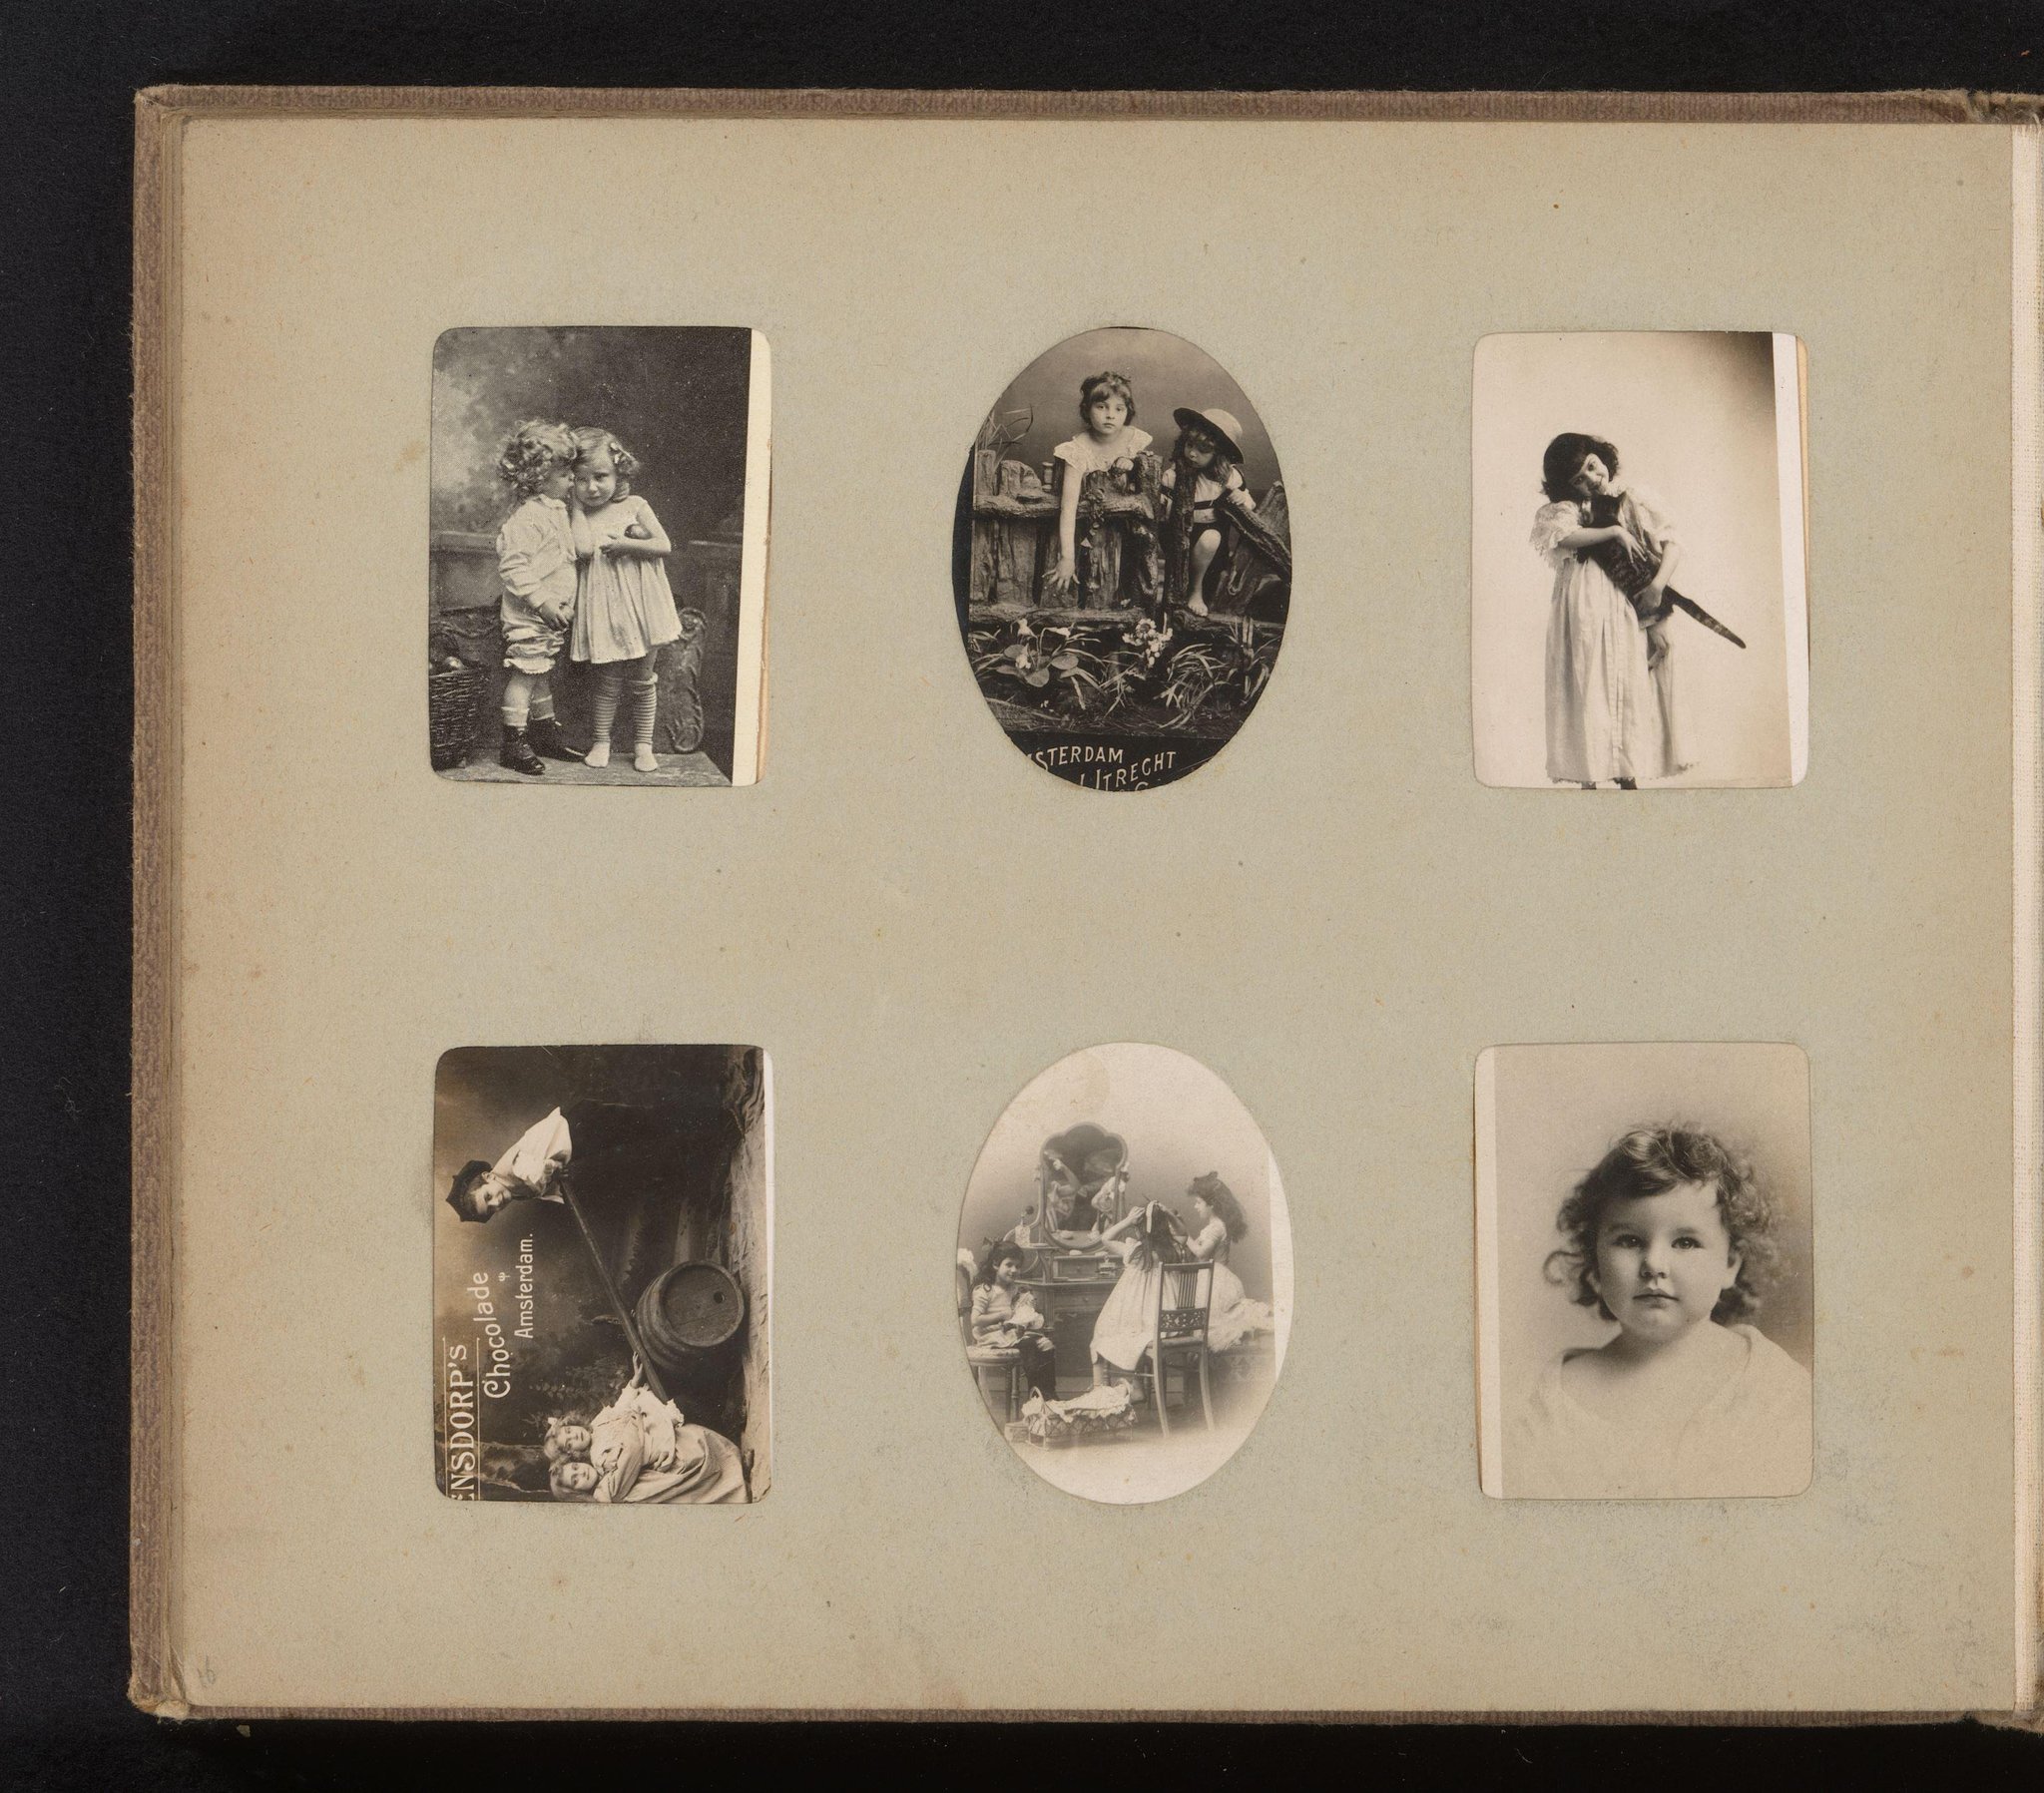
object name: photomechanical print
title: Portretten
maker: Anonymous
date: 1890-1900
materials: cardboard, paper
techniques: gelatin silver print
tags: london, cat, child (at home)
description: Zes portretten van kinderen waaronder een van een meisje met een kat en een van meisjes aan een kaptafel. Deze pagina is deel van een album.